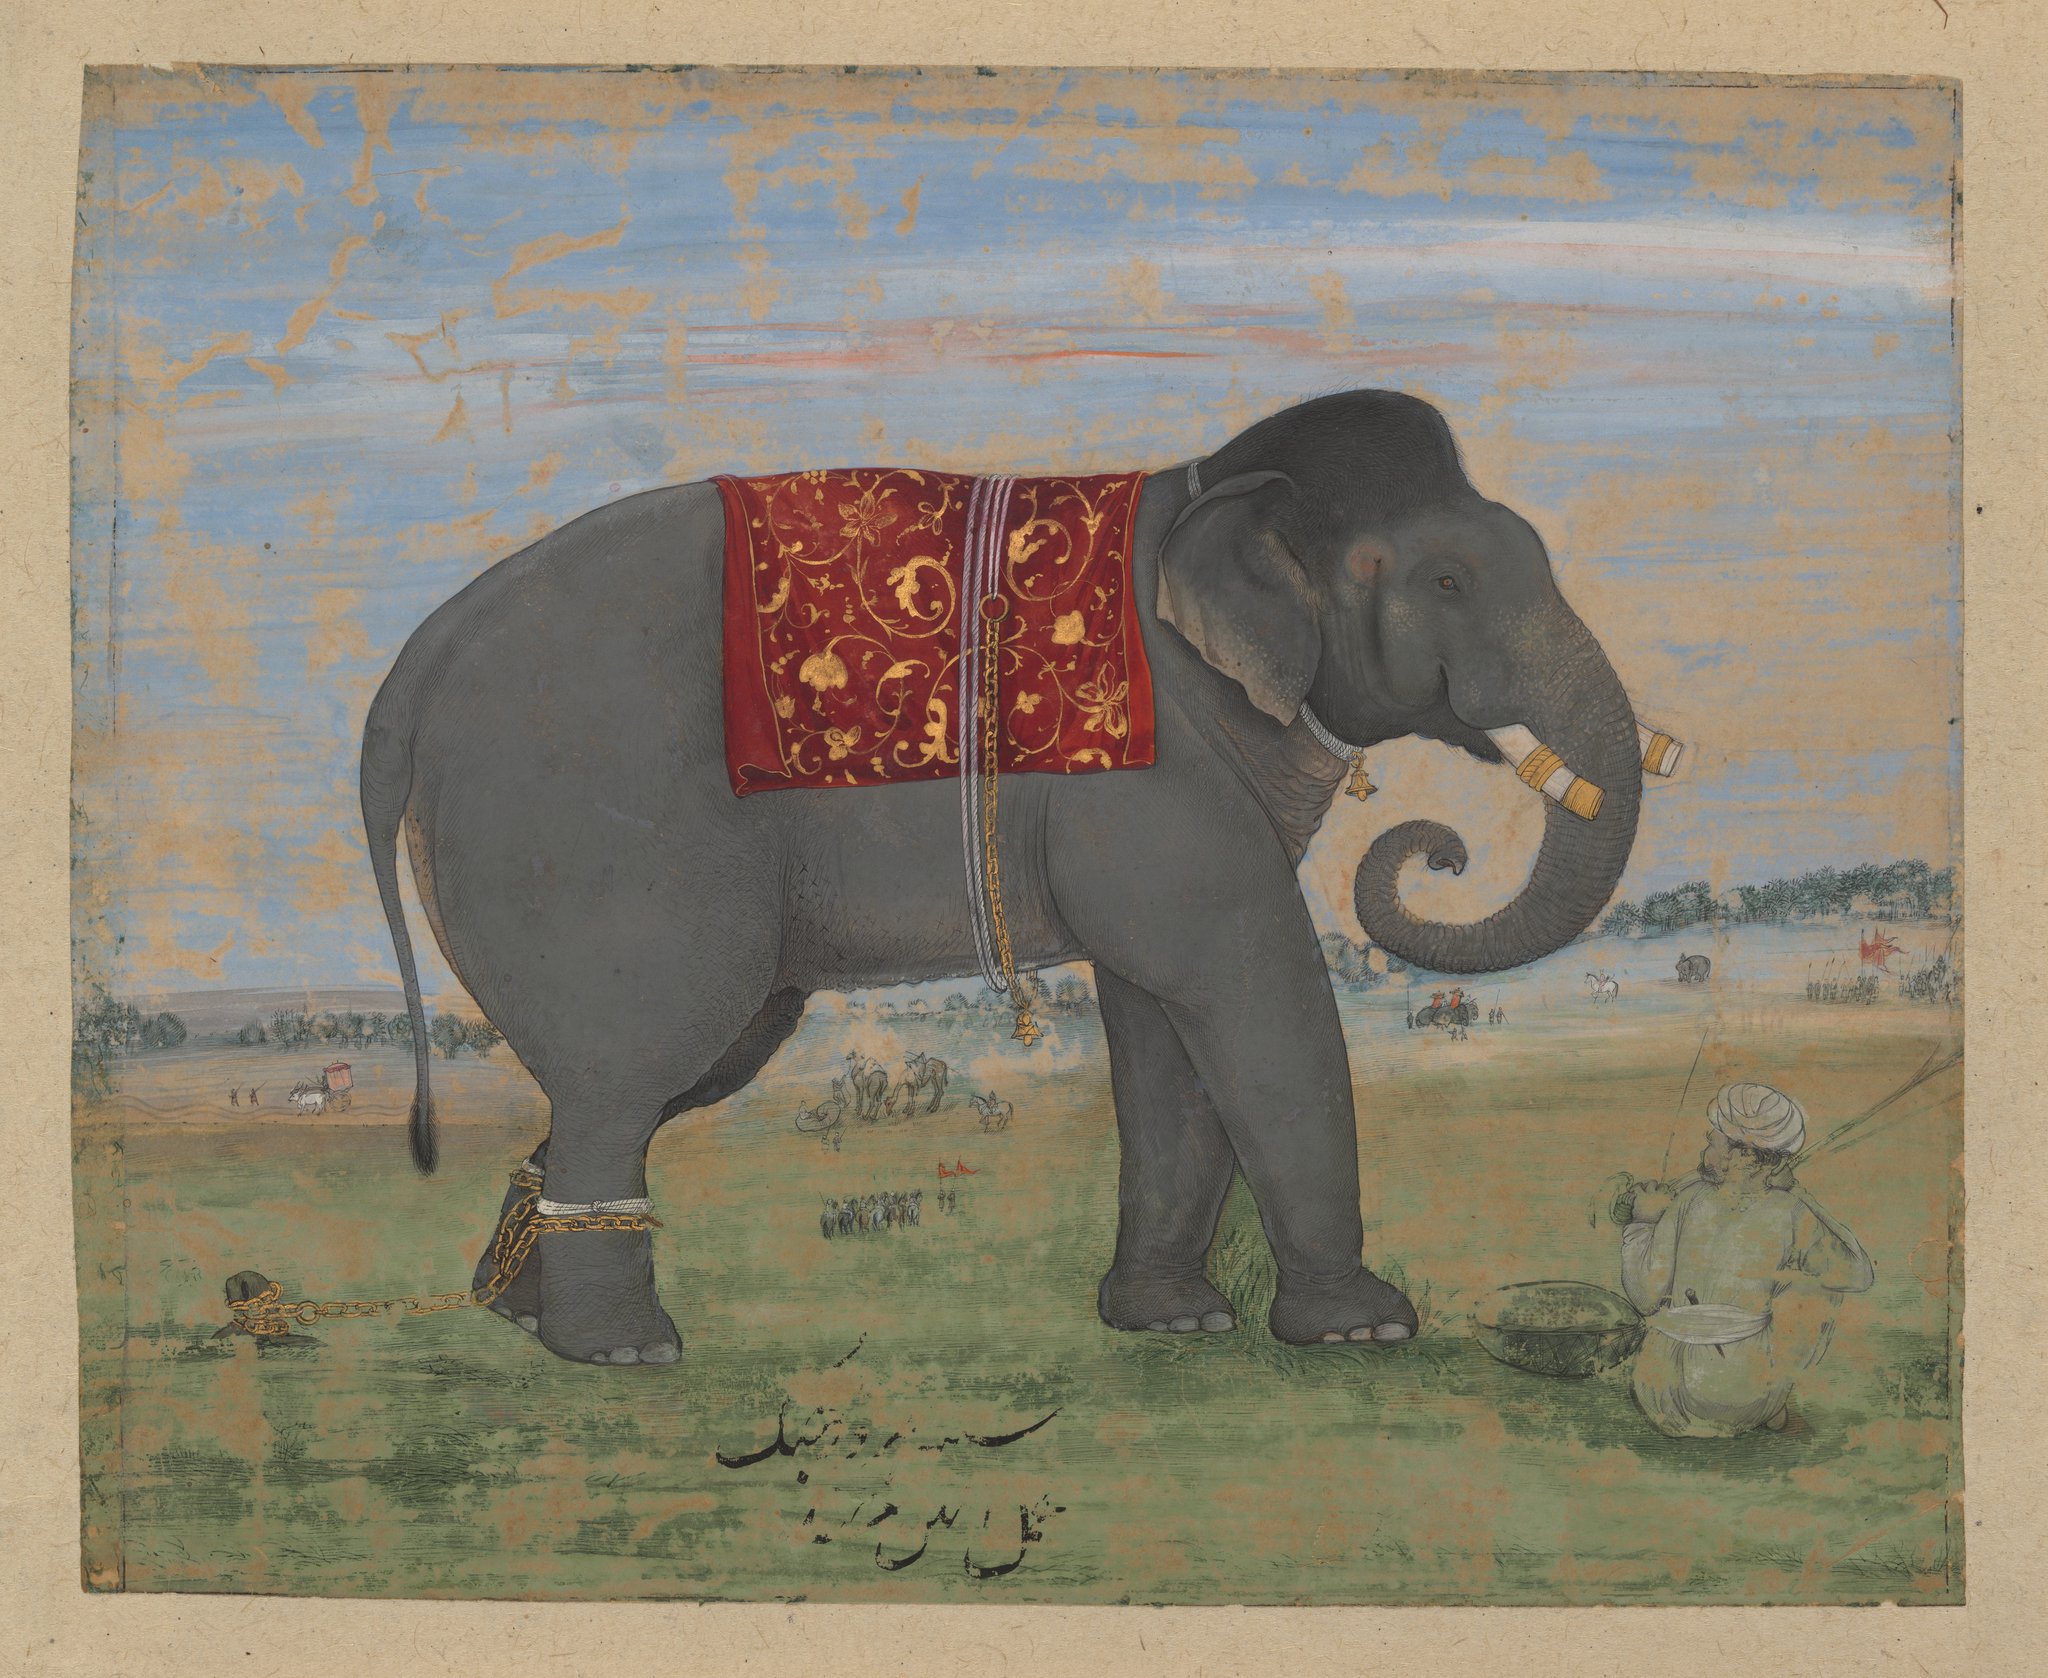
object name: illustrated single work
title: An Elephant and Keeper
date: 1650-1660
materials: gold, paper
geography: india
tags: elephants